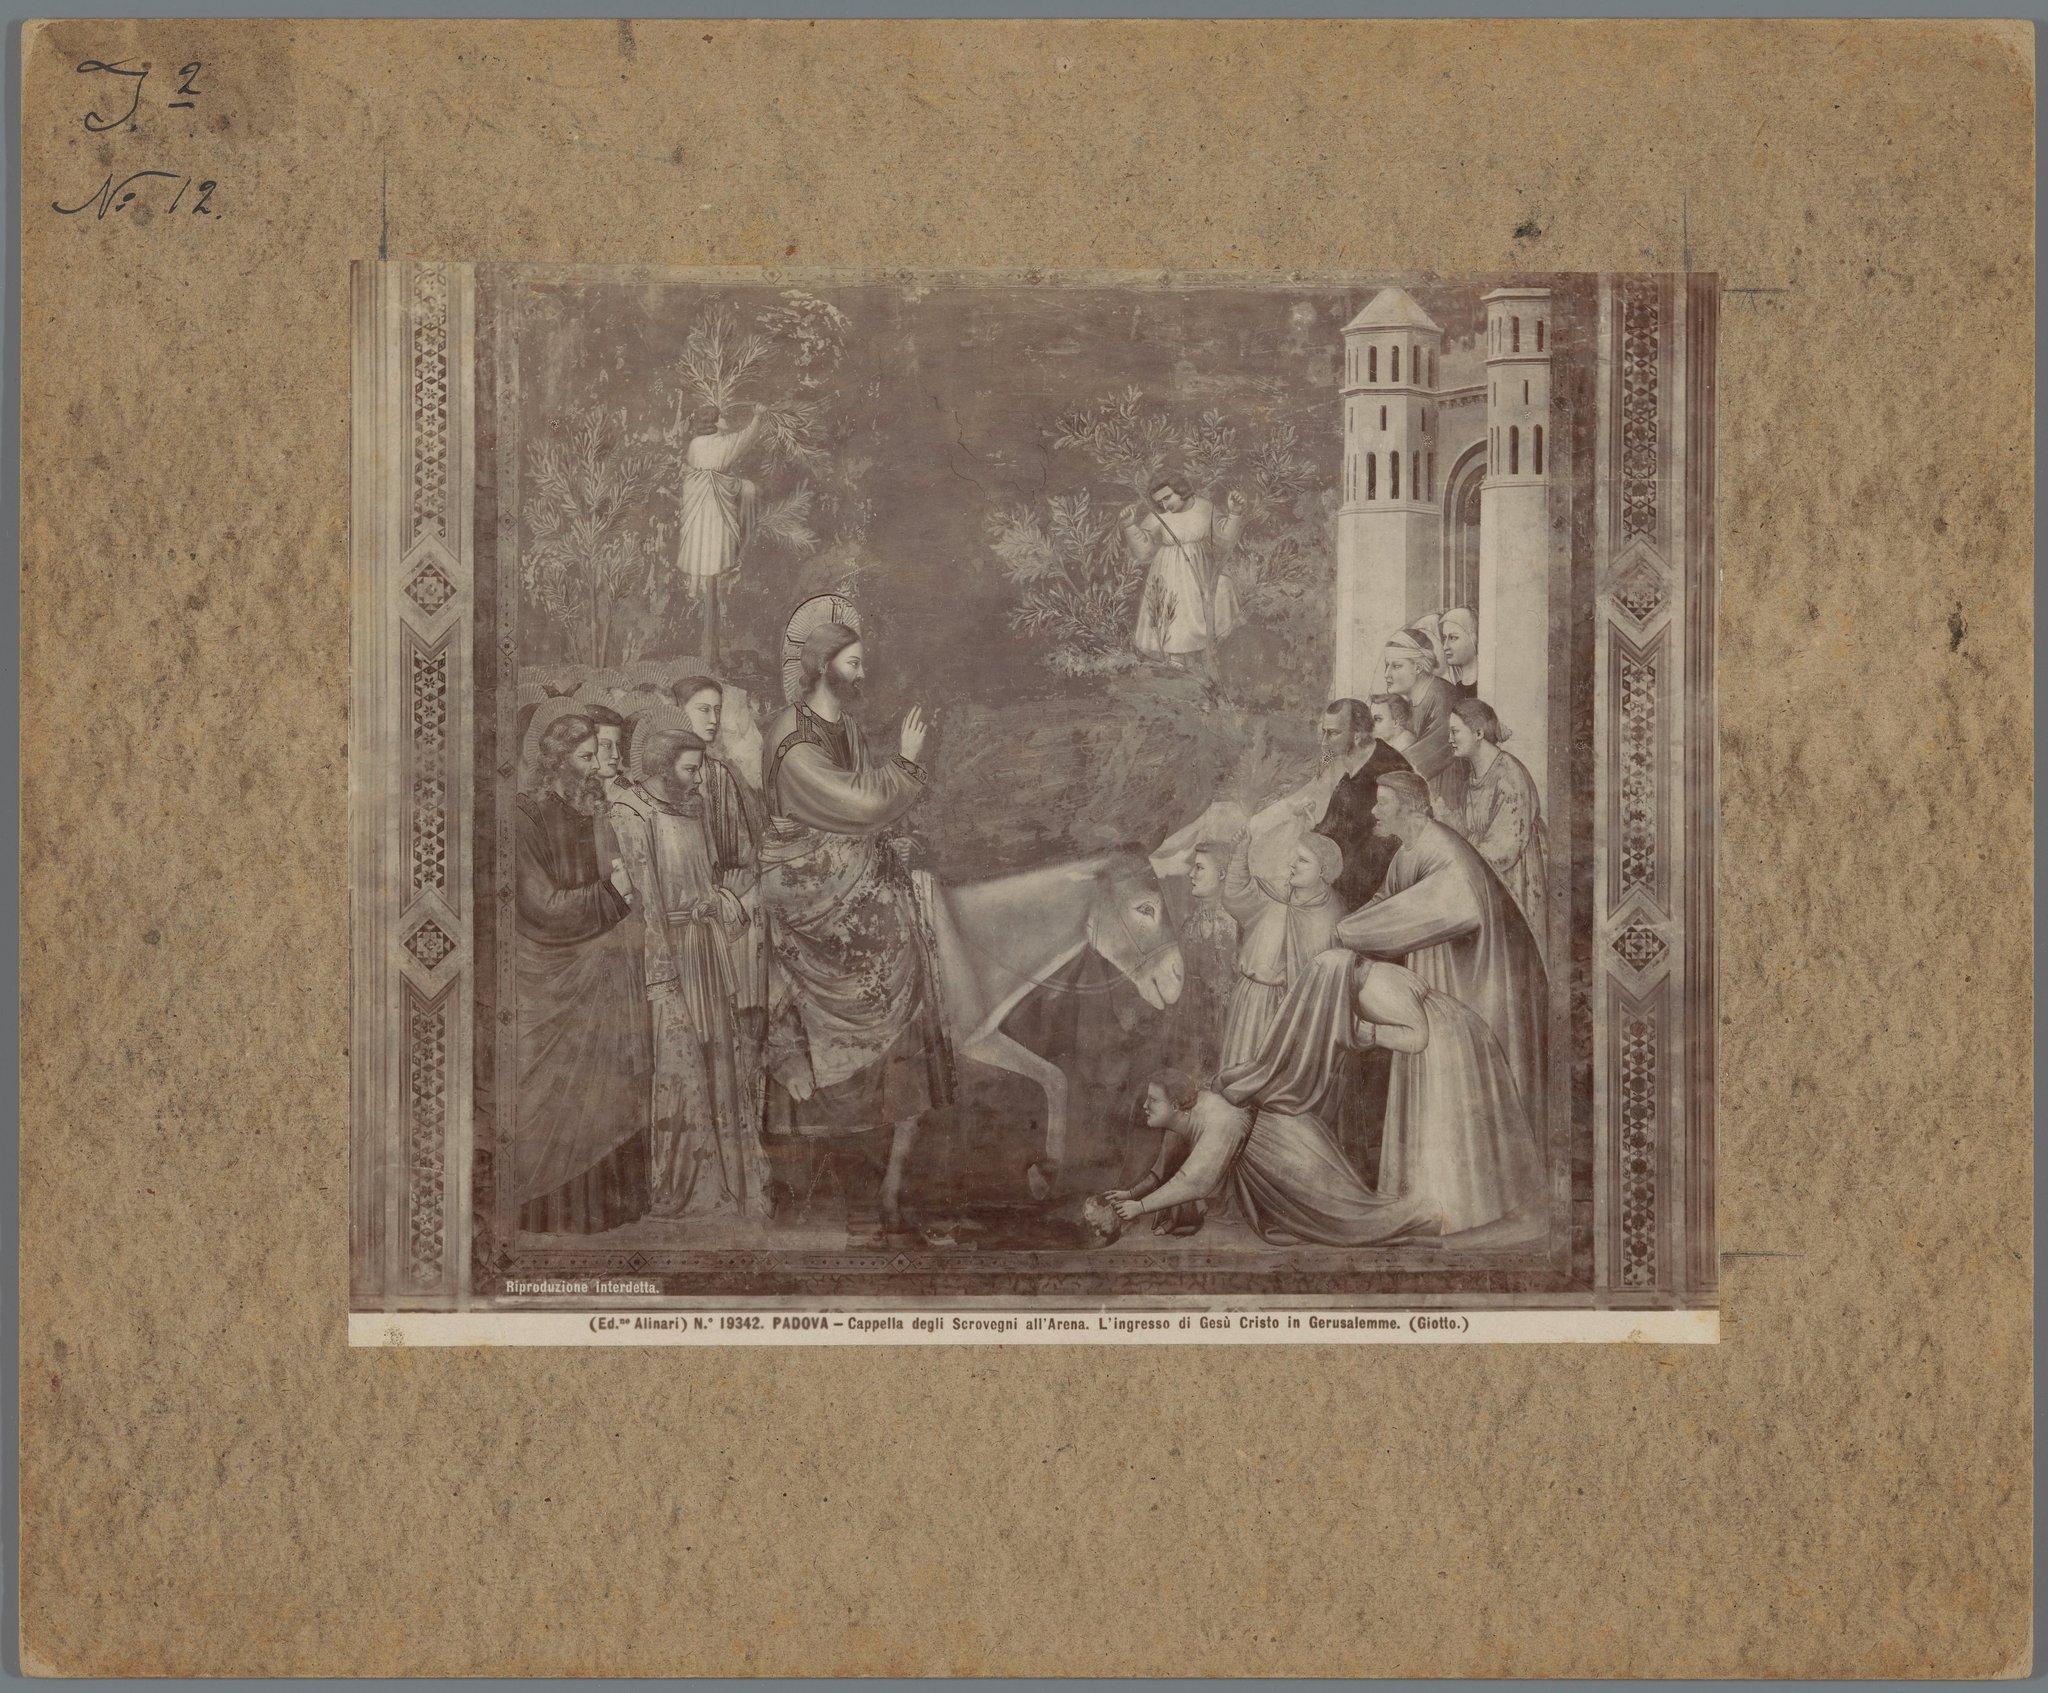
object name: photograph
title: PADOVA - Cappella degli Scrovegni all'Arena. L'ingresso di Gesù Cristo in Gerusalemme.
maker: giotto de bondone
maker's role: painter, sculptor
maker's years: 1266-1337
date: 1875-1900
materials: cardboard, photographic support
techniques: albumen print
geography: scrovegnikapel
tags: entry into jerusalem: people spreading their clothes before christ on the ass, and waving palm branches (matthew 21:1-11, 21:14-16; mark 11:1-11; luke 19:28-40; john 12:12-19)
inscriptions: inscription: ‘Venetie 9 afdekken 18 x 24/3 cliché x 8,8 cm onderfacet 2mm’, collector's mark: Lugt 3937, number: ‘P.e 2.a N.o 19342.’